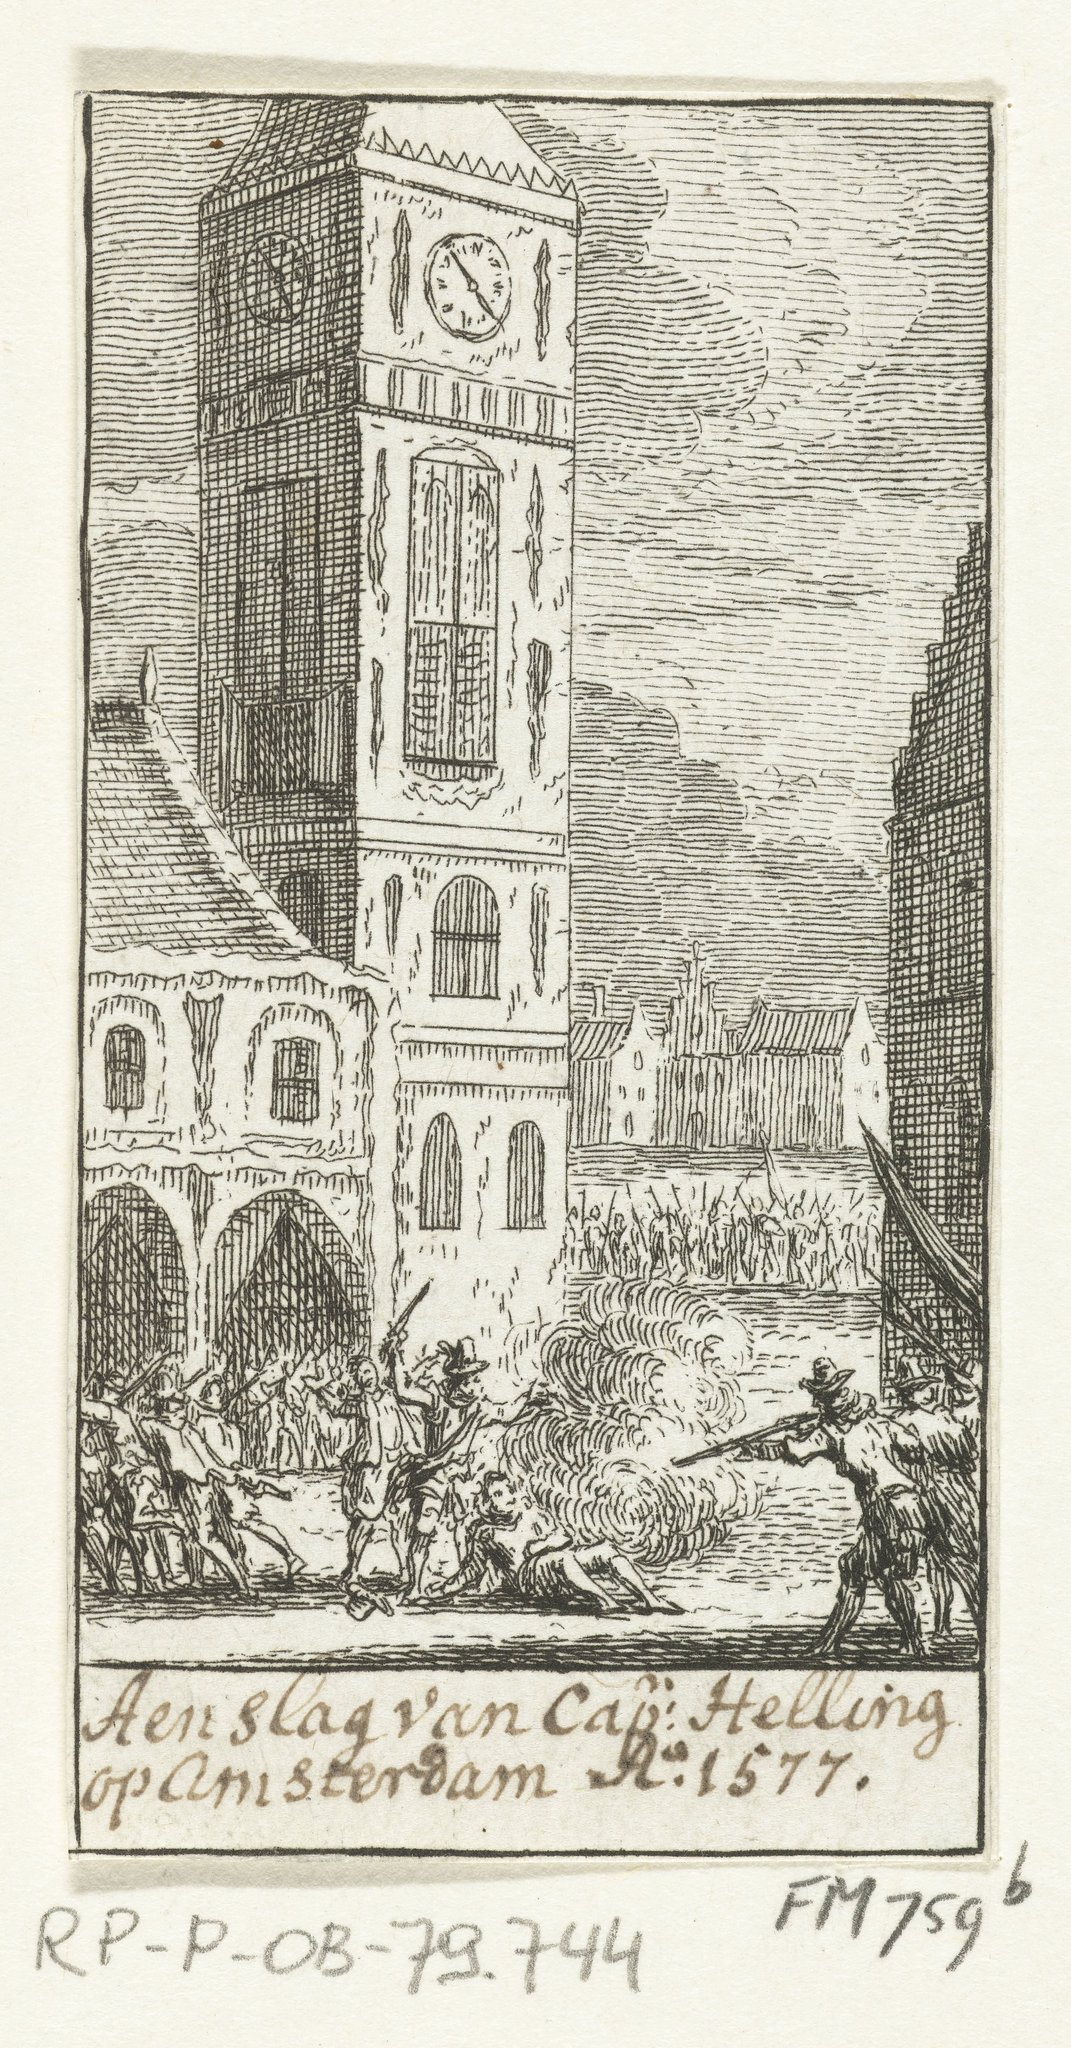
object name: print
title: Aanslag van Helling op Amsterdam, 1577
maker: simon fokke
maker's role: draughtsman, print maker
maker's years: 1712-1784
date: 1722-1784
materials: ink, paper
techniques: etching, pen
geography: northern netherlands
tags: amsterdam, haarlem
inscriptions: inscription: ‘Aen slag van Cap.n Helling op Amsterdam Ao. 1577.’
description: Aanslag van Helling en Ruychaver op Amsterdam, 23 november 1577. Gevechten op de Dam voor het stadhuis.